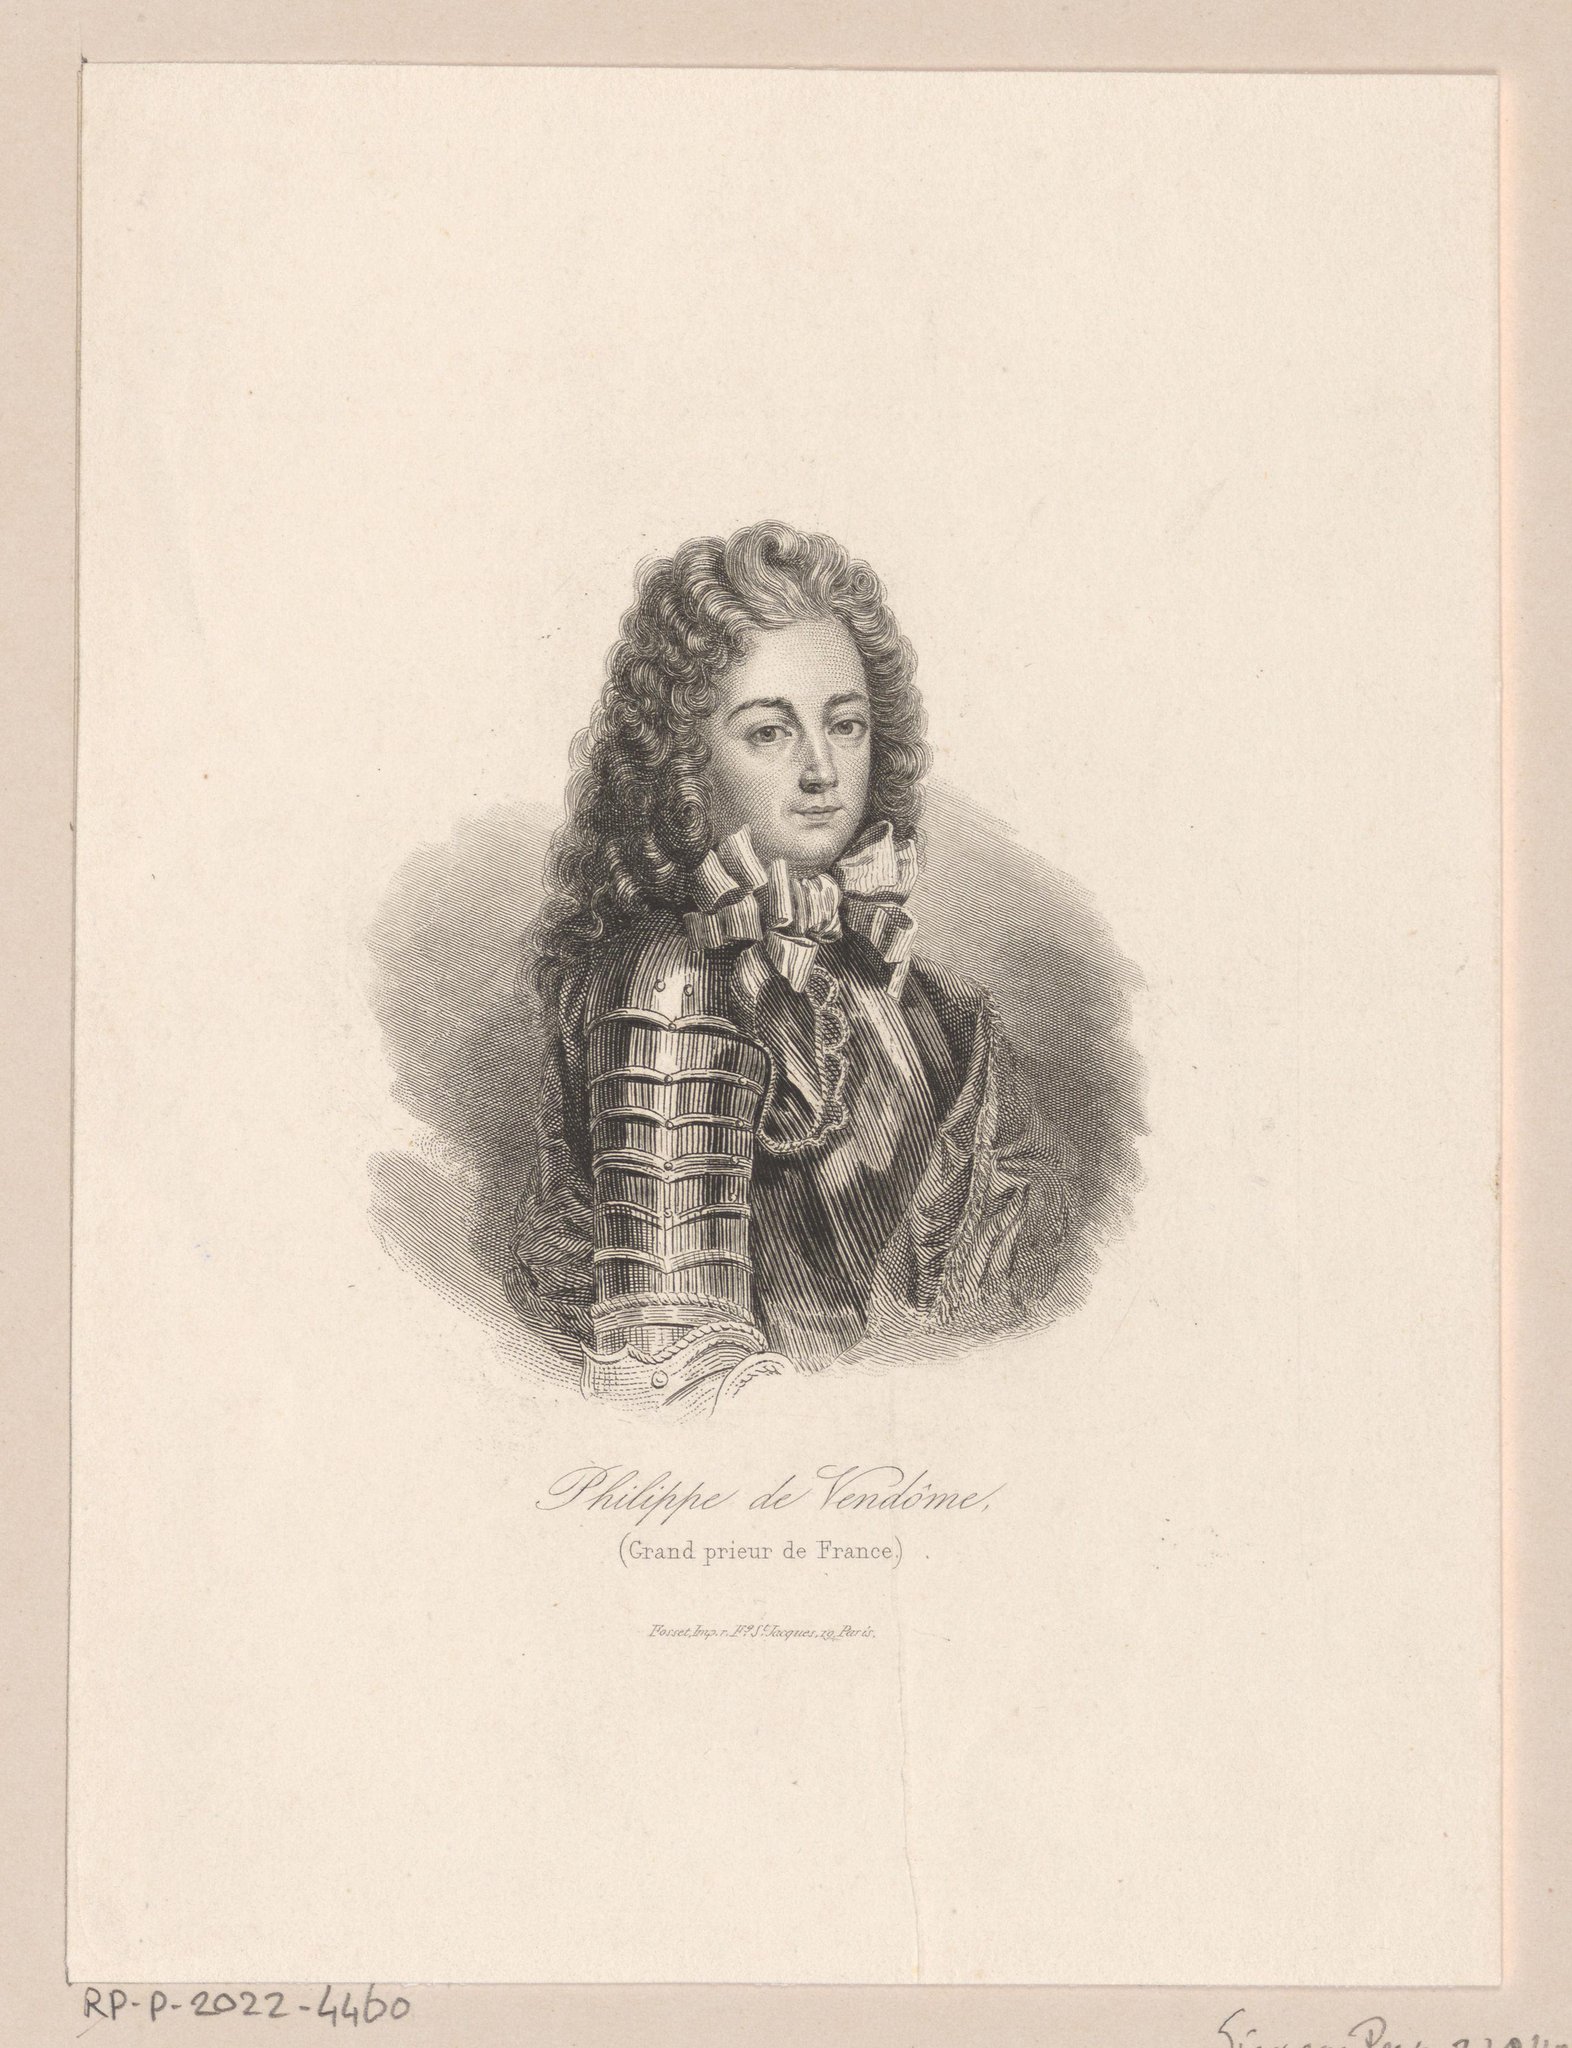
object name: print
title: Portret van Philippe, hertog van Vendôme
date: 1820-1870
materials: paper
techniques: engraving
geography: paris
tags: paris, armour, historical persons